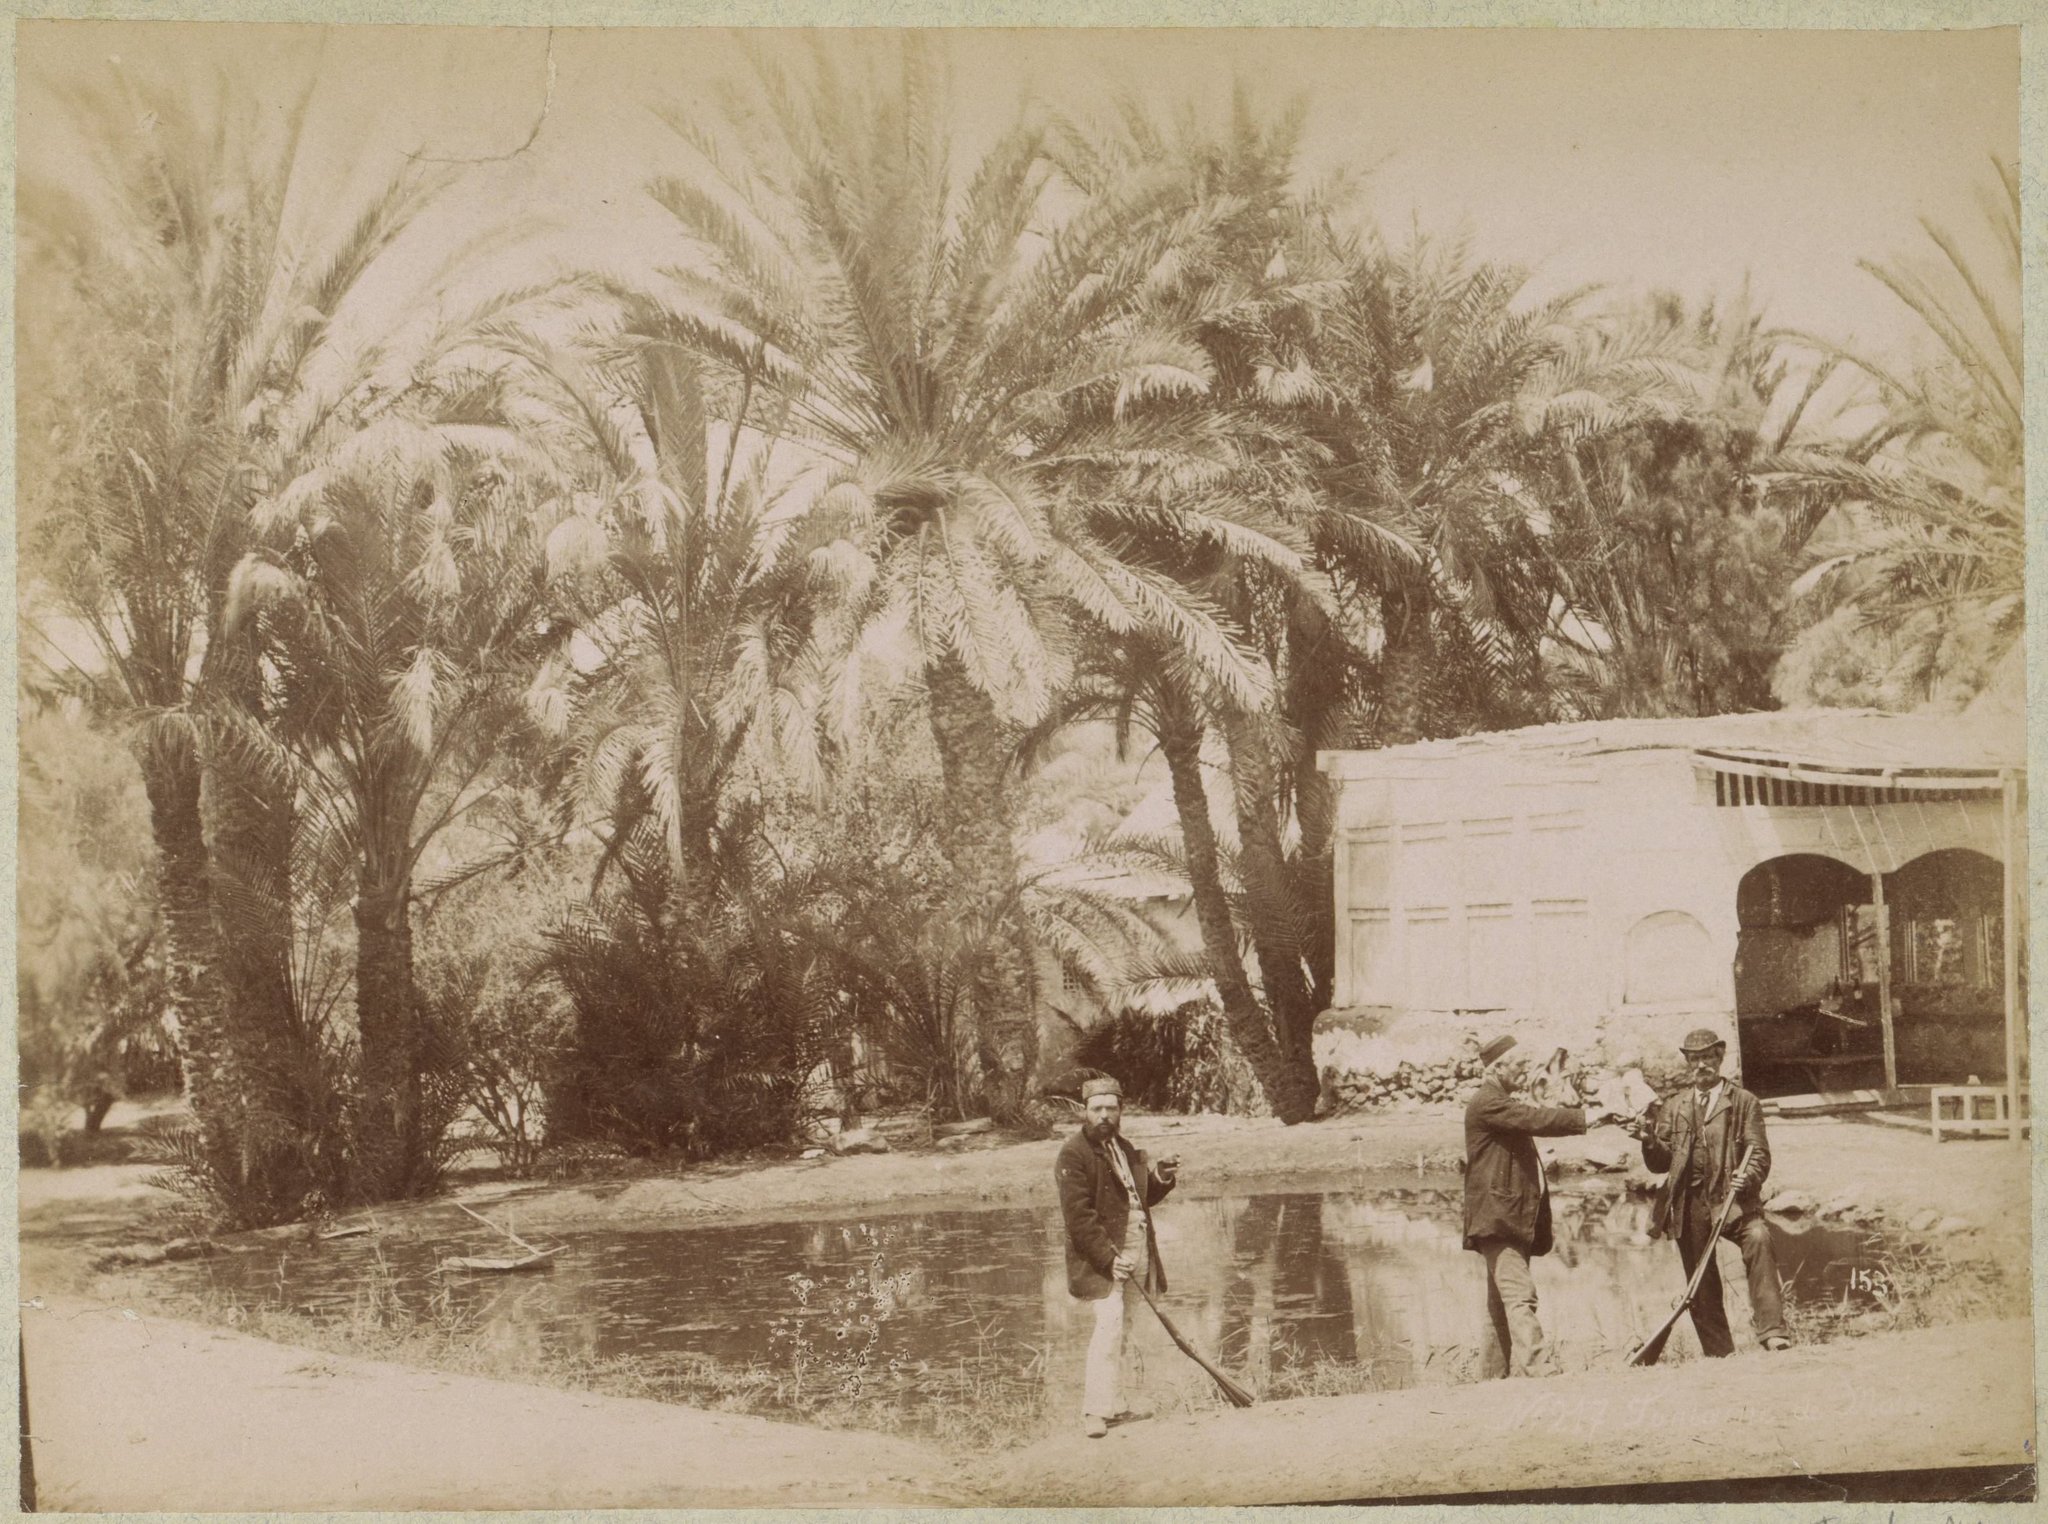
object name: photograph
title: Drie mannen met geweren en glazen in de hand staand bij een water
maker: hippolyte arnoux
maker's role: publisher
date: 1870-1891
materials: paper, photographic support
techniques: albumen print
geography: taiwan strait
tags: group-portrait of hunters, pond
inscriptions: number: ‘217’, number: ‘158’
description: Onderdeel van Fotoalbum van een reis naar Manilla.